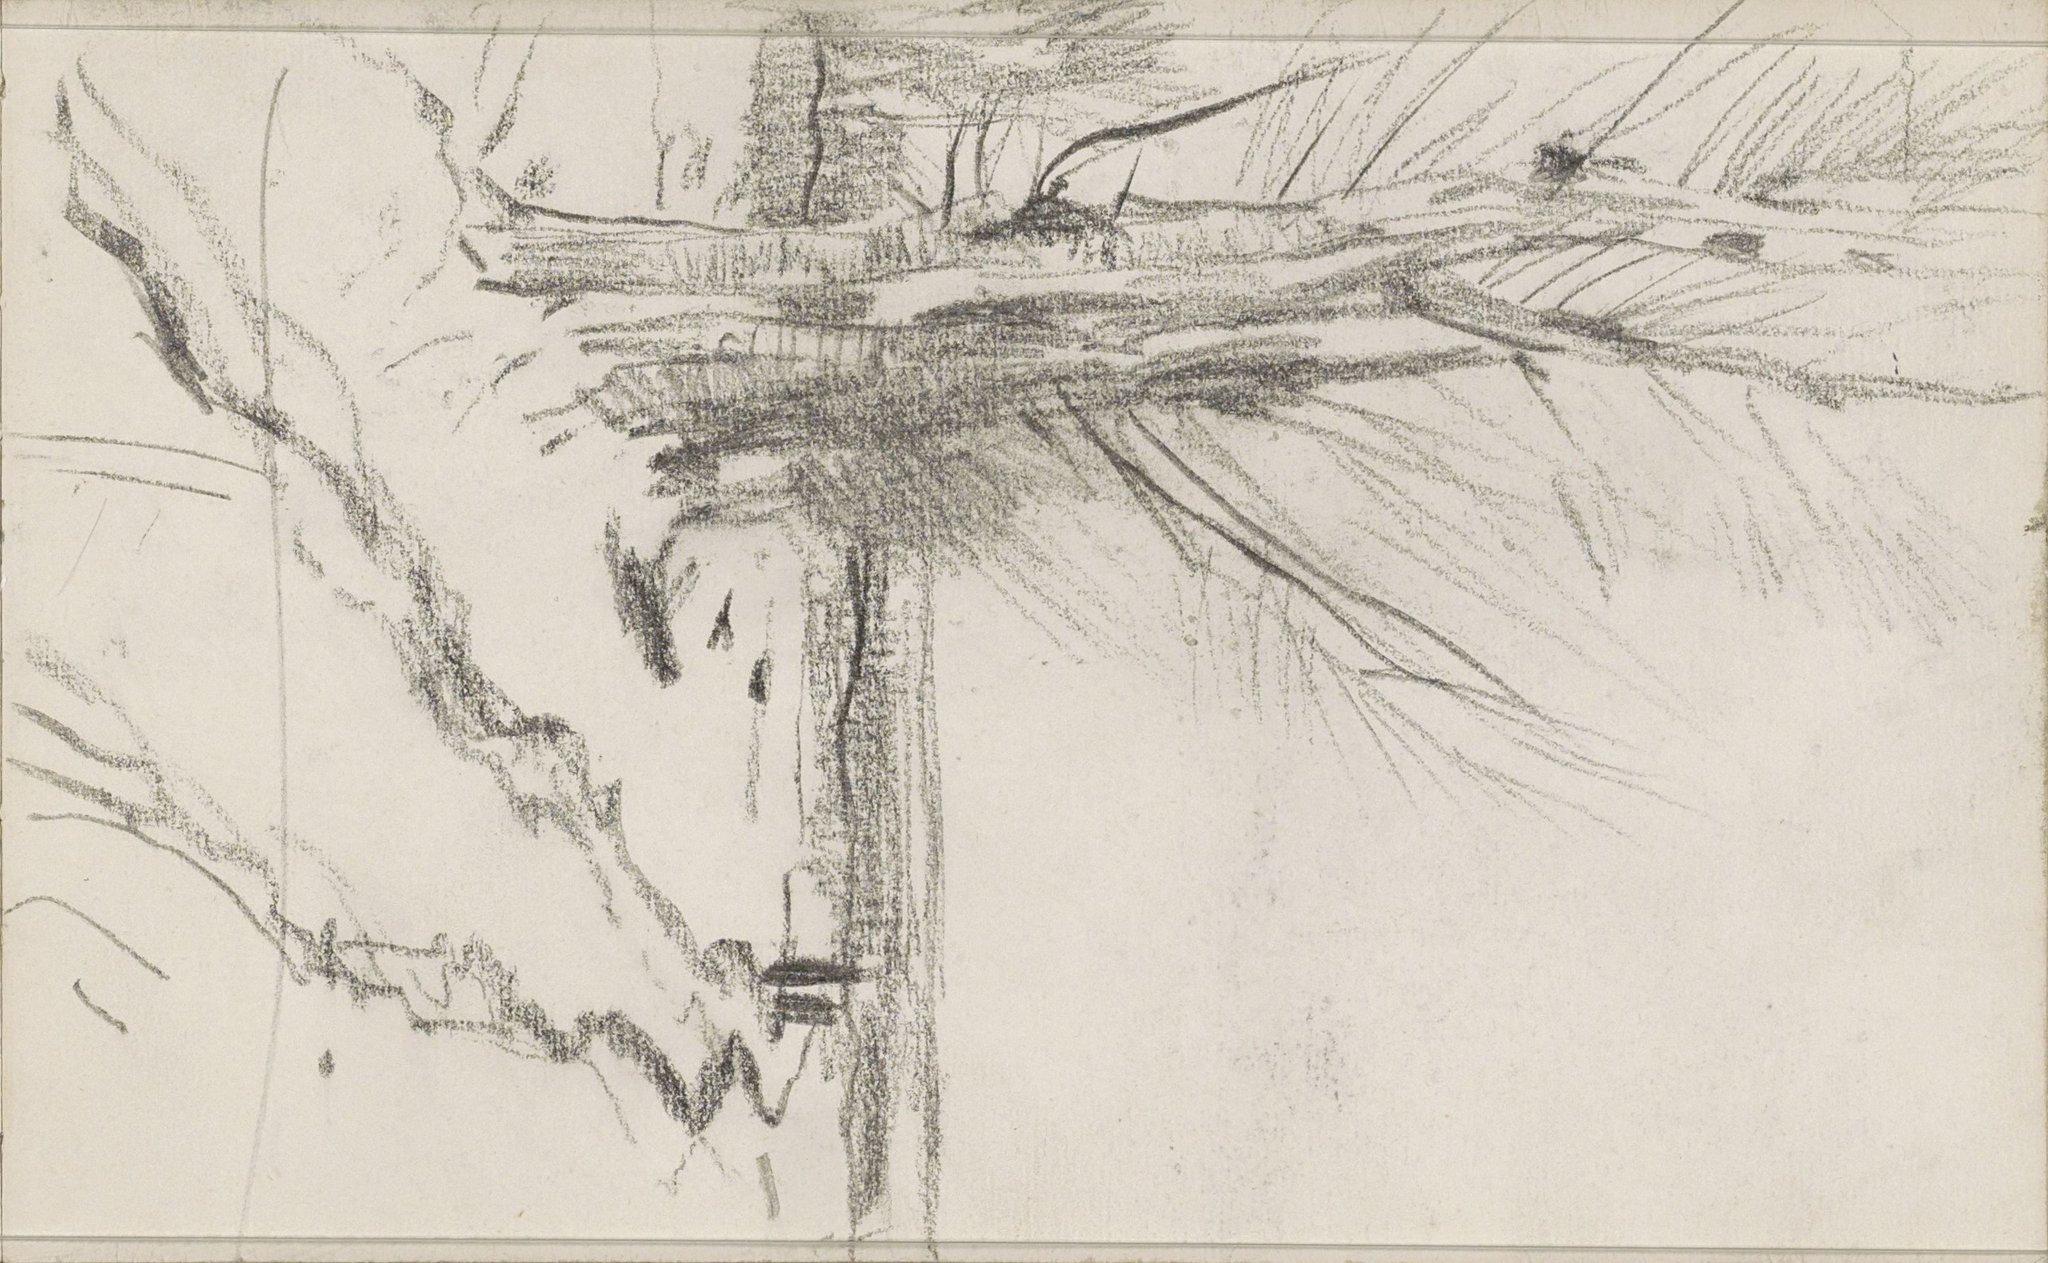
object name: sketchbook leaf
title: Landschap met een pad langs een groep bomen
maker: anton mauve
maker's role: draughtsman, painter, print maker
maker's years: 1838-1888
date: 1848-1888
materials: chalk, paper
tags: landscapes, road, path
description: Blad 30 recto uit een schetsboek met 41 bladen.